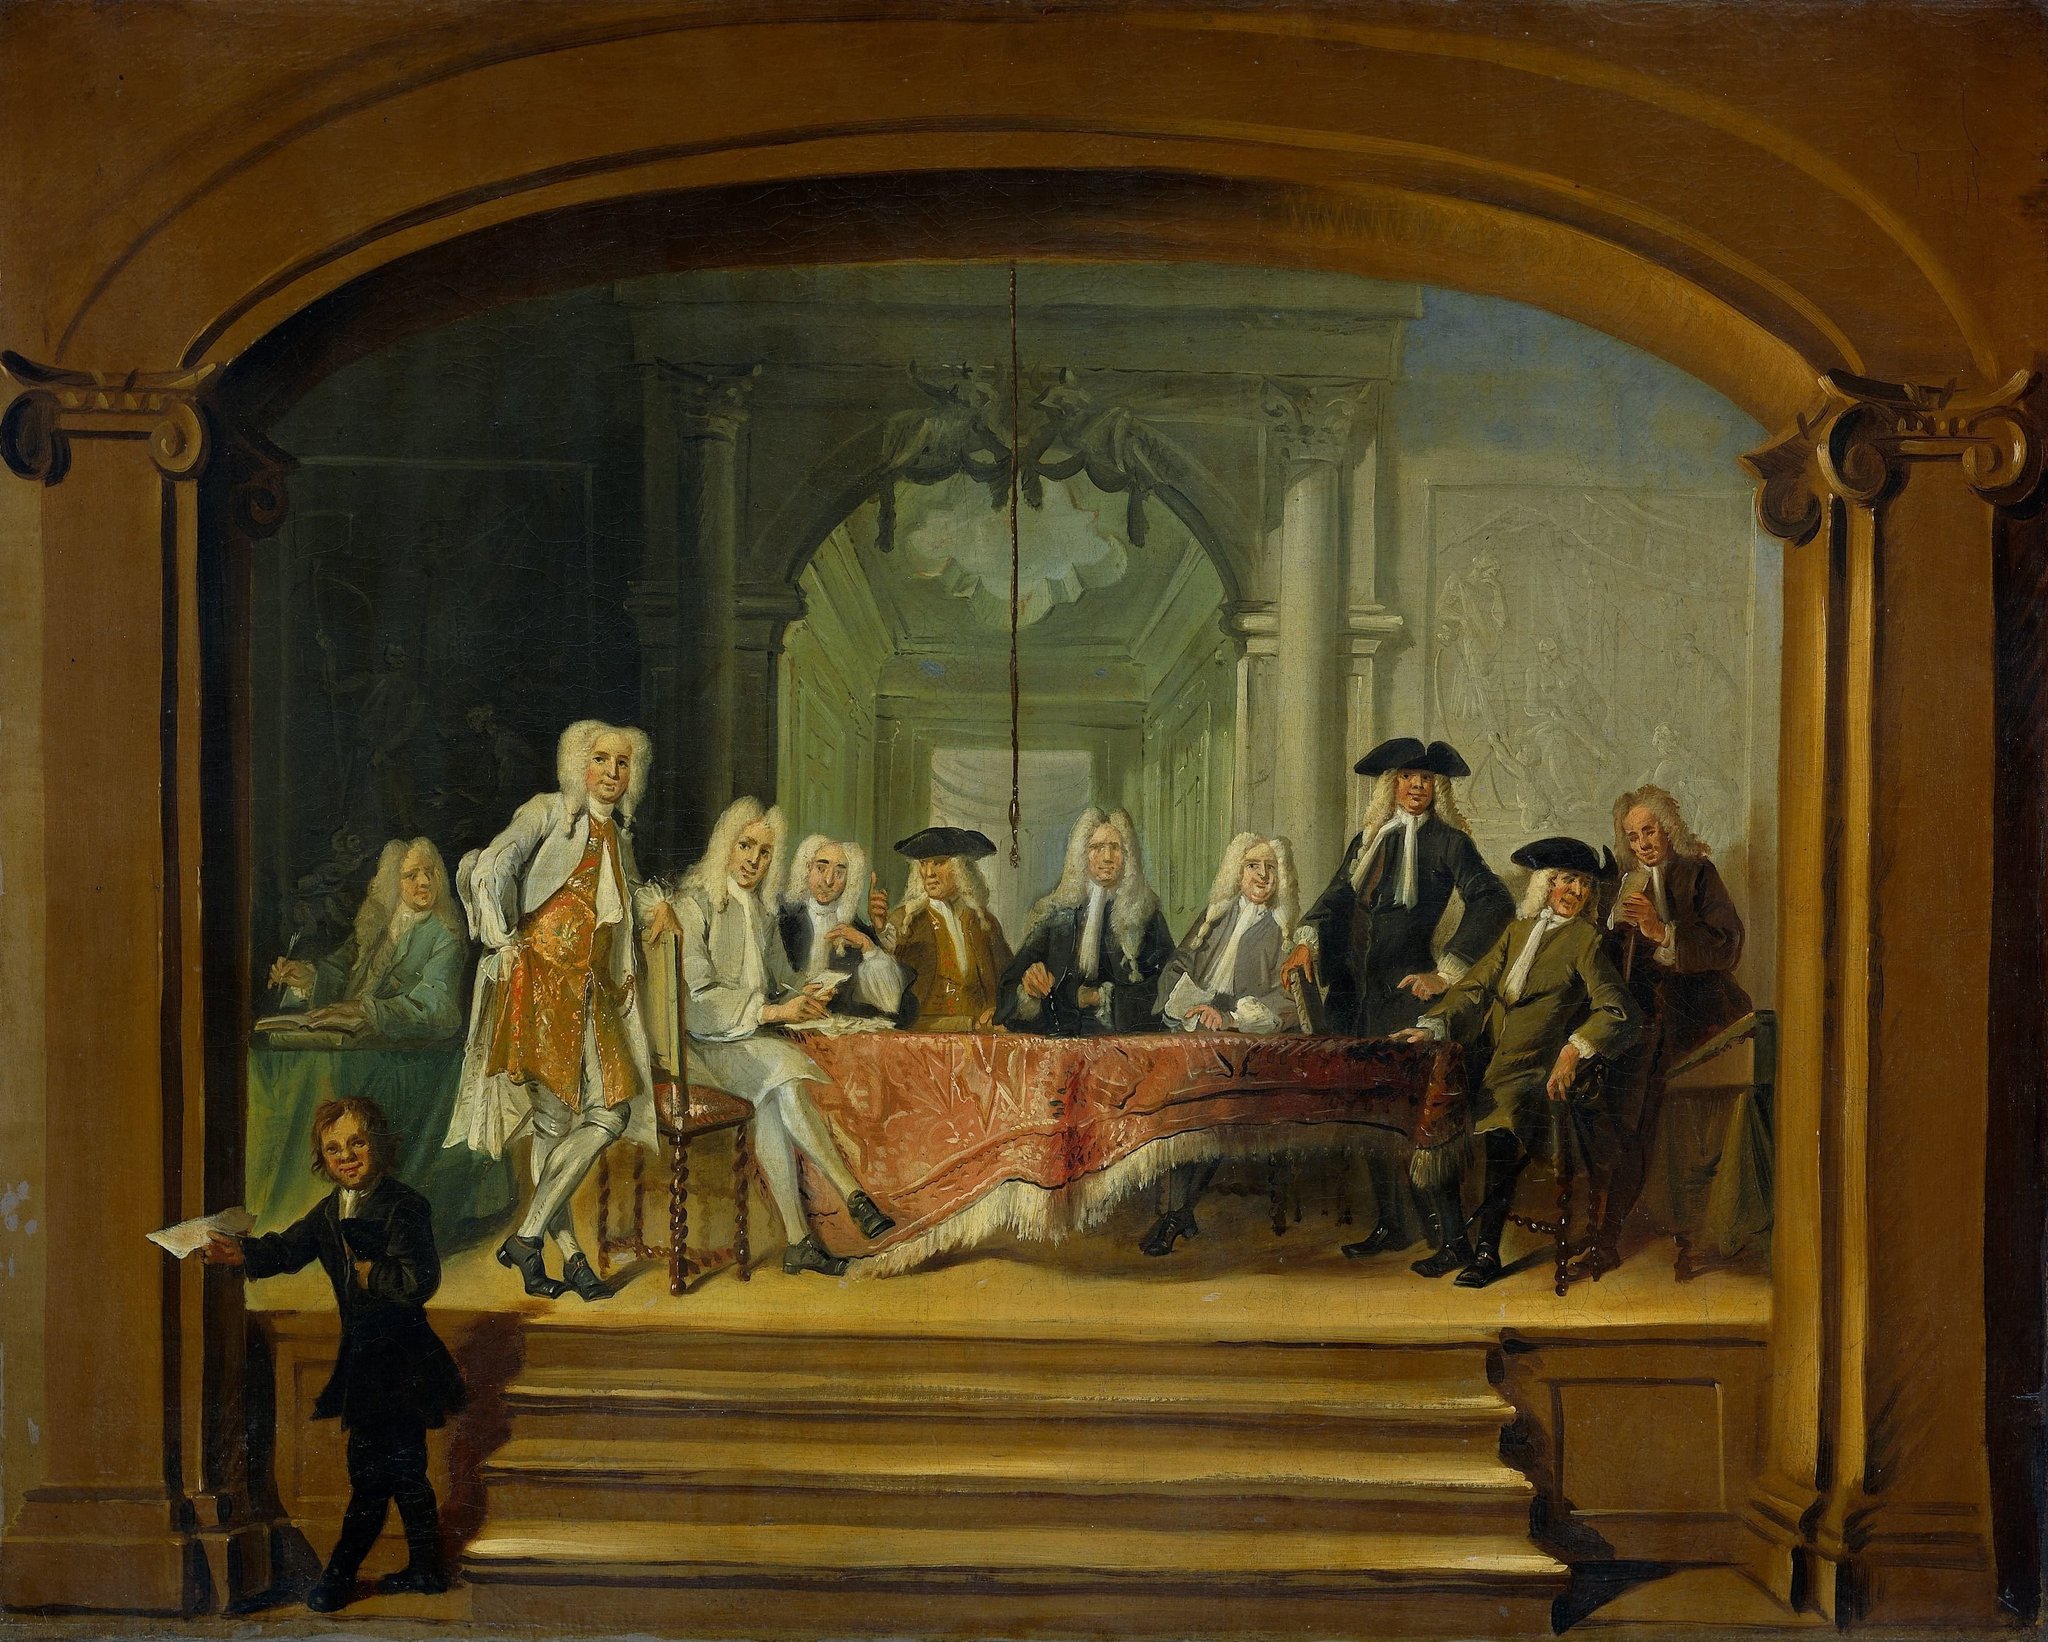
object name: preparatory study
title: Regents of the Aalmoezeniersweeshuis Orphanage in Amsterdam, 1729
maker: cornelis troost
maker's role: draughtsman, painter, print maker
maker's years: 1696-1750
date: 1729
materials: canvas, oil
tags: historical persons, board, esp. governors, trustees, etc. (dutch: 'regenten'), orphanage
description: De regenten van het Aalmoezeniersweeshuis te Amsterdam in 1729. Voorstudie voor het groepsportret (SK-C-87). De regenten zittend en staand rond een tafel, links op de voorgrond staat een weesjongen met een blad papier in de hand.